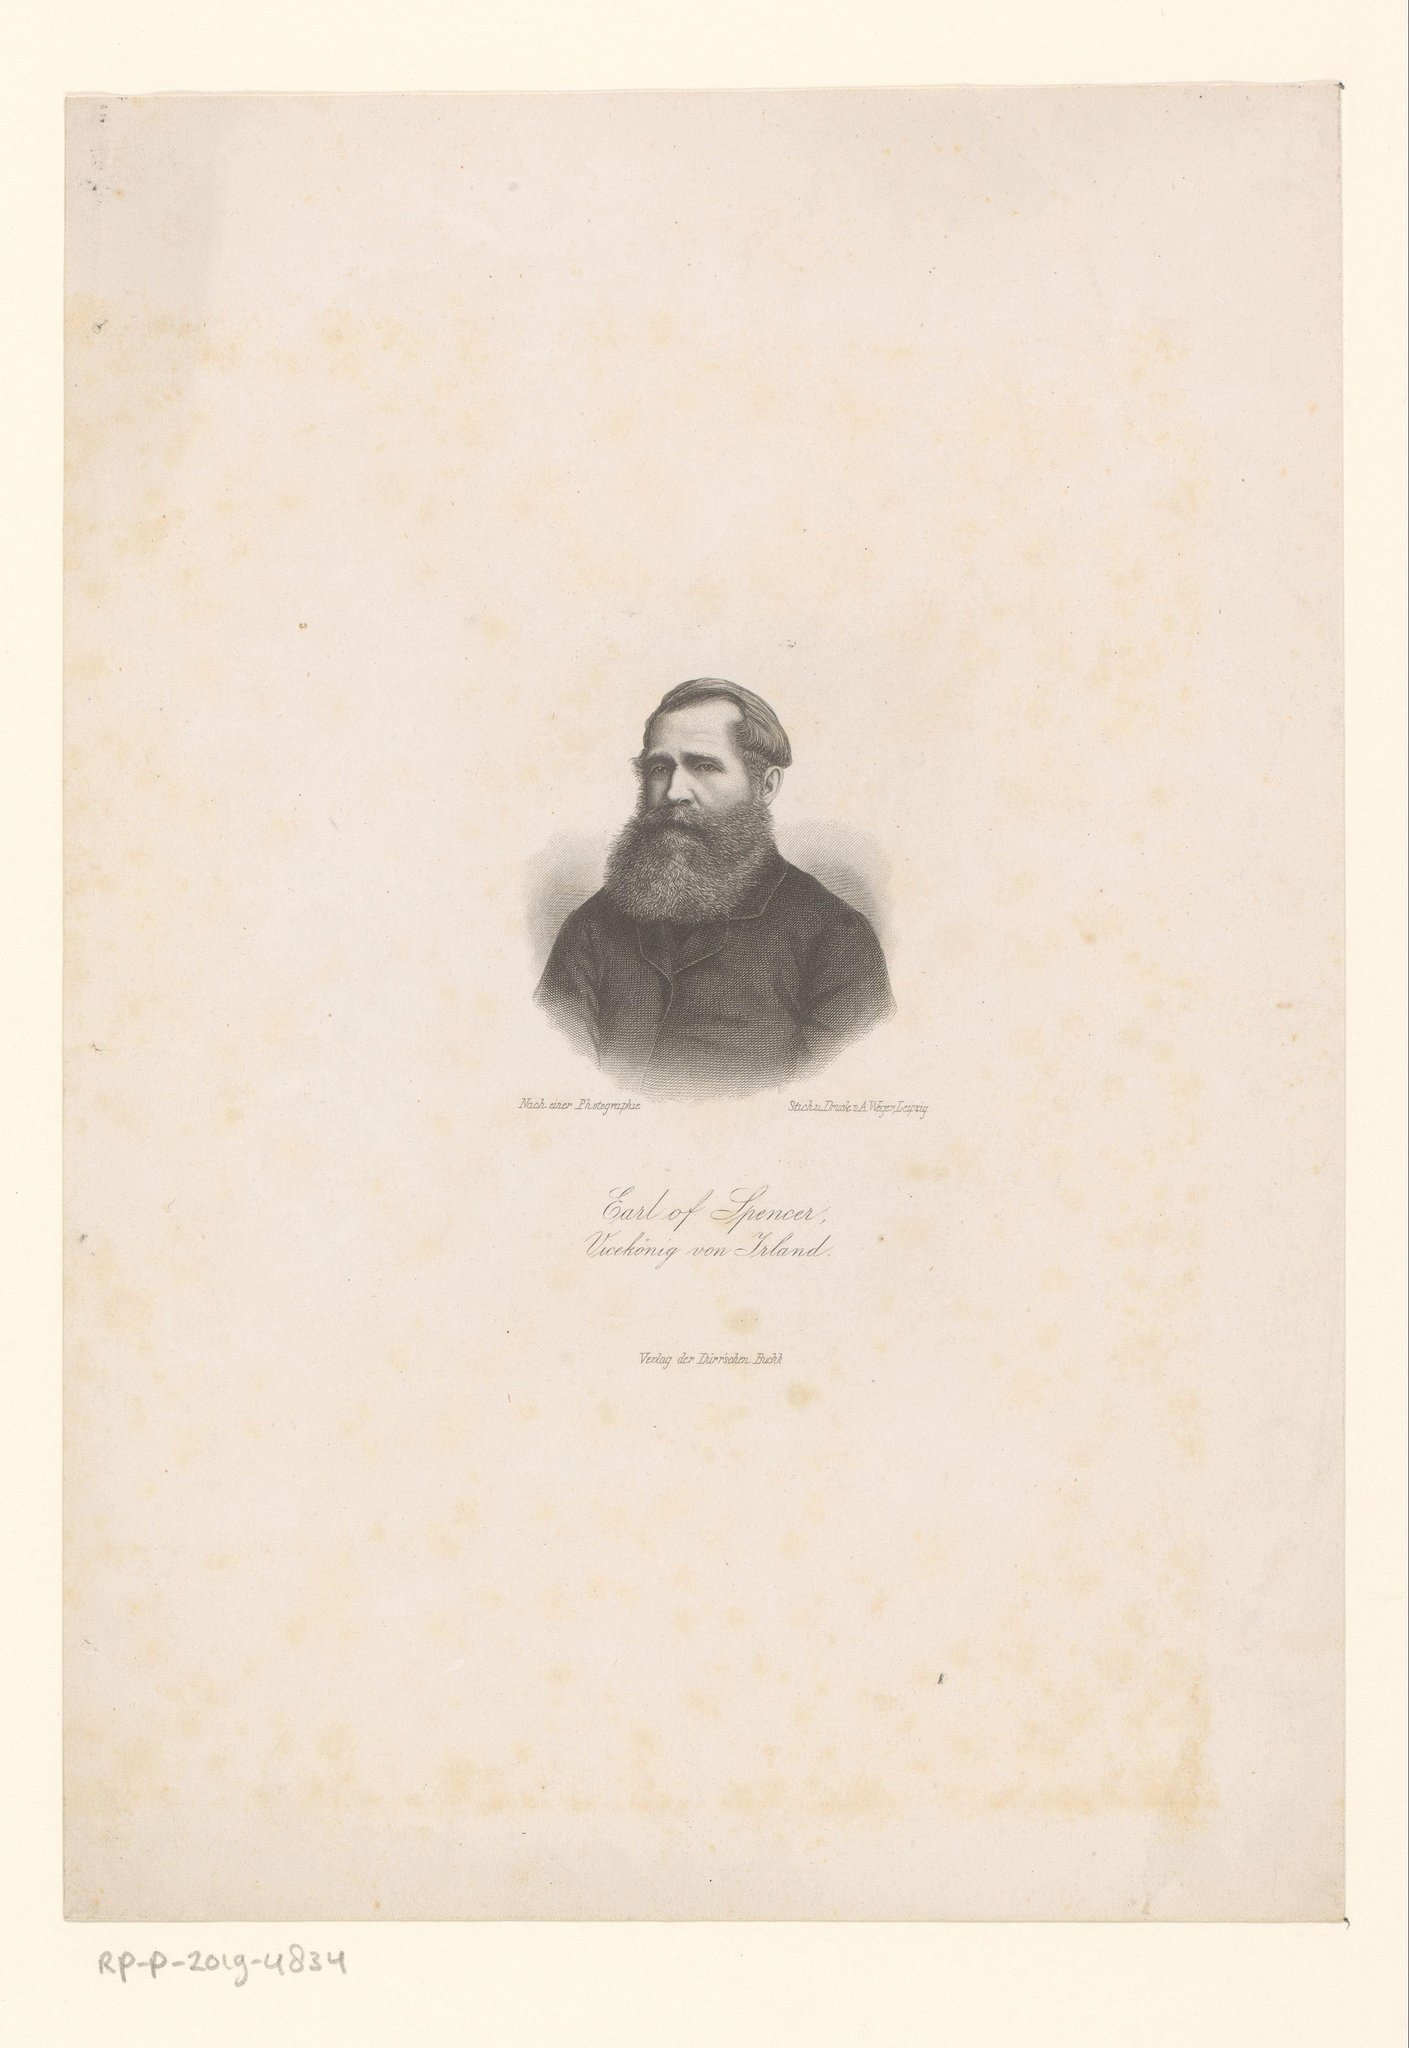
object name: print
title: Portret van John Spencer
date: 1878-1892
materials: paper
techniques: etching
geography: leipzig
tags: historical persons, politician, e.g. party leader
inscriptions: collector's mark: Lugt 2228, collector's mark: Lugt 2760